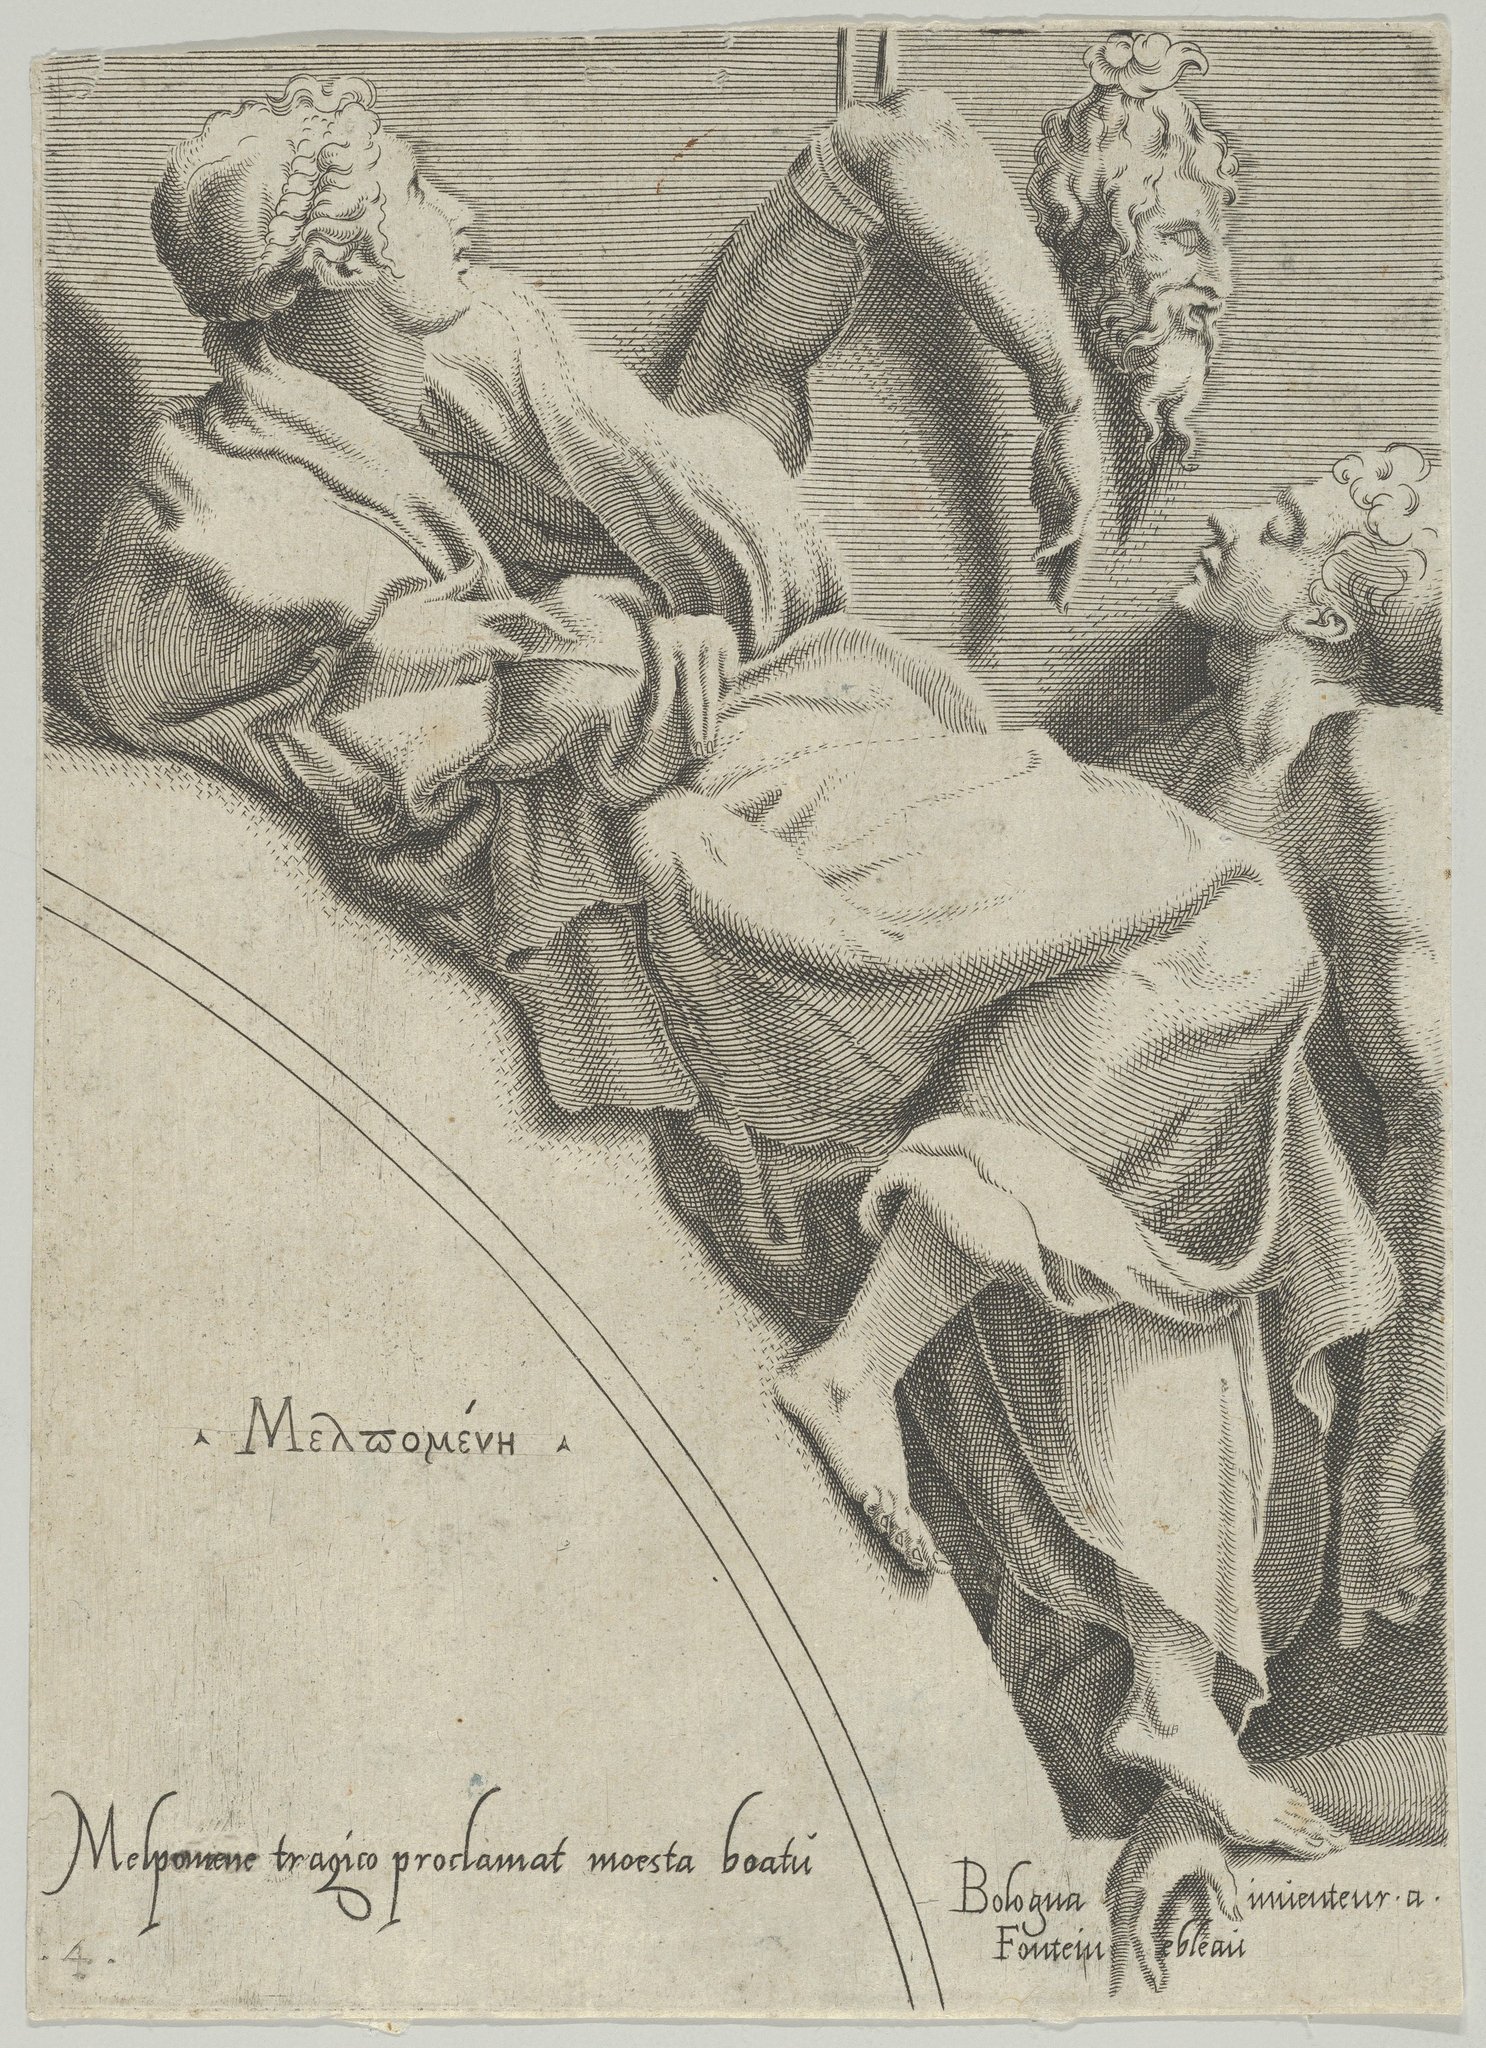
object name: print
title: Melpomene, from "The Muses and the Three Goddesses"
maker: anonymous, french-italian, 17th century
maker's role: artist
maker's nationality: french italian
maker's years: 1600-1700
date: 1540-1545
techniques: engraving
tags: muses